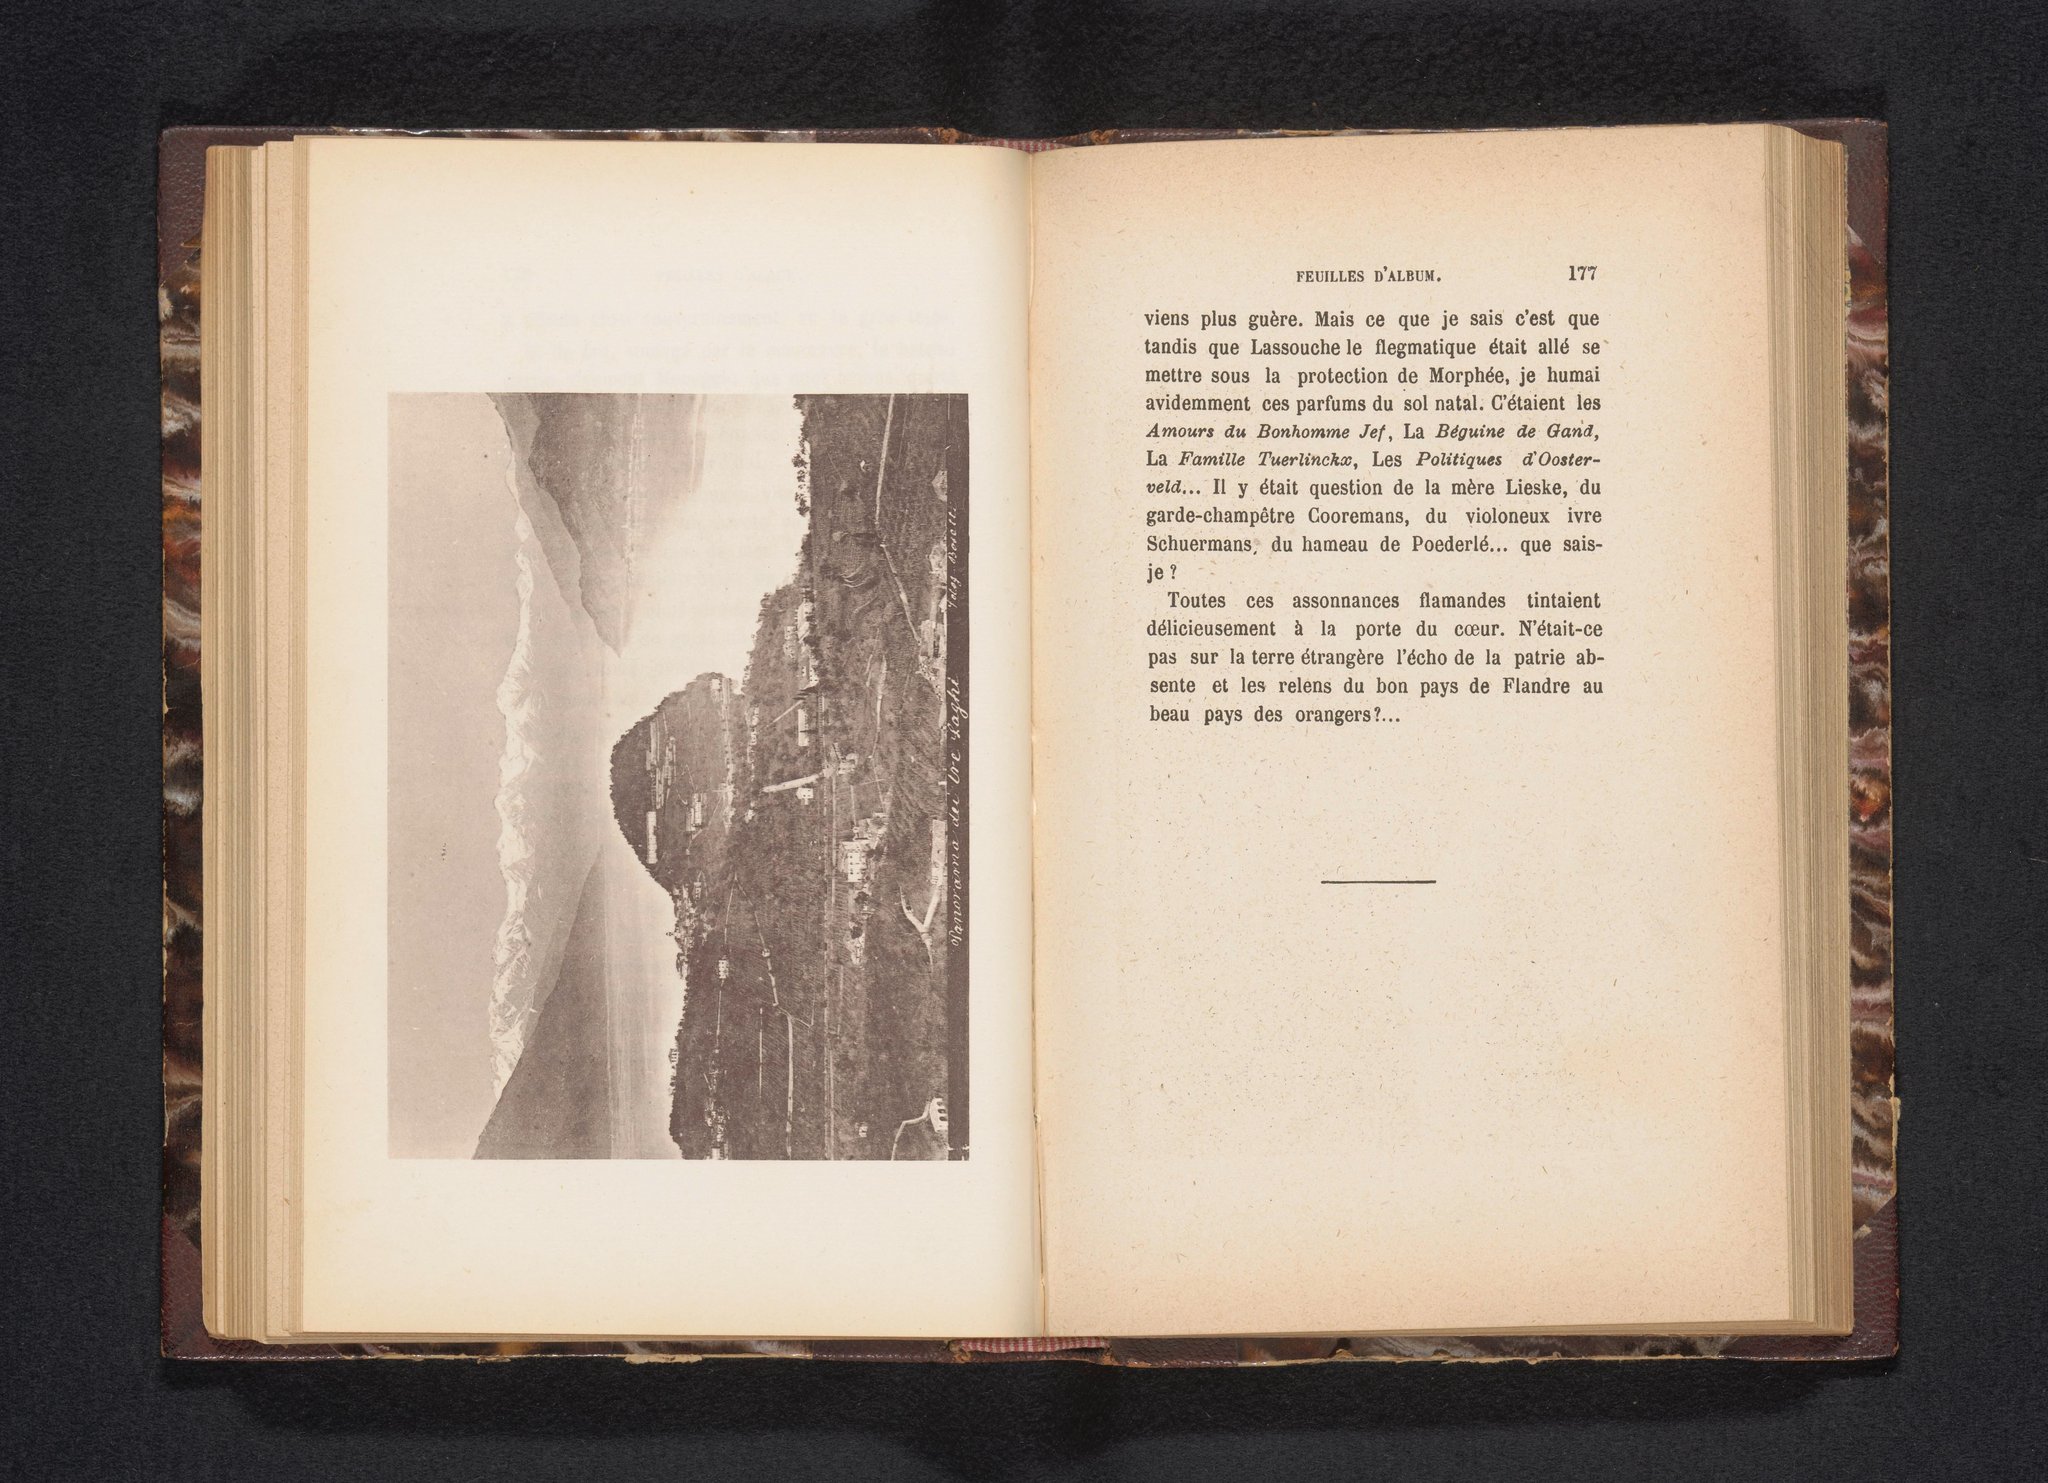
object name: photomechanical print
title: Gezicht op Bellagio en het Como meer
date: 1884-1889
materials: paper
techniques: photograph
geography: bellagio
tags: city-view in general; 'veduta', lake, mountain-range, snow peaks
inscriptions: inscription: ‘fotog ... Boratt[...]’